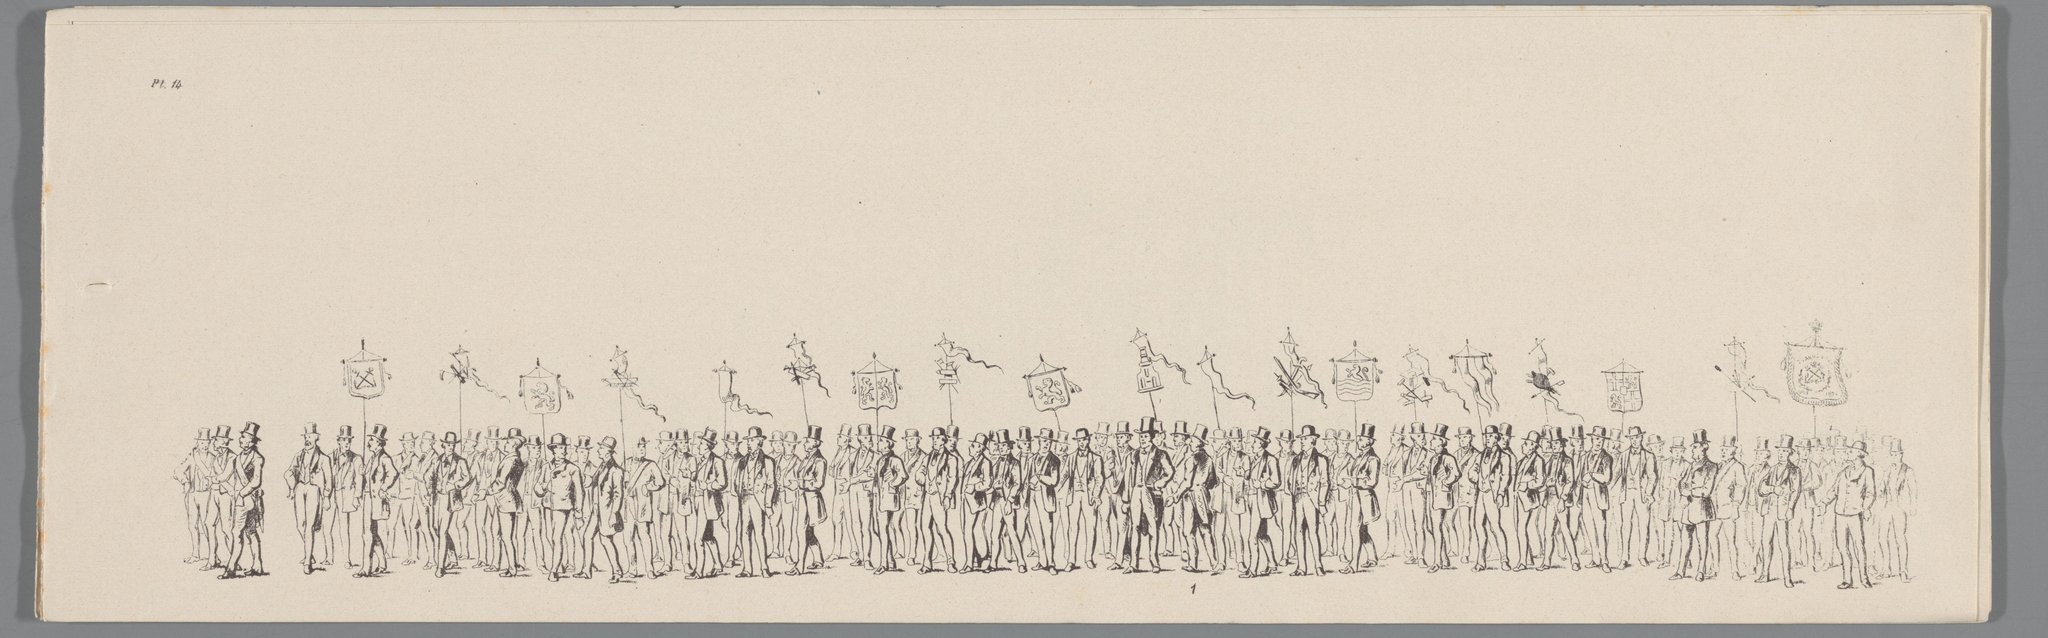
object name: print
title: Historische en Allegorische Optocht te Amsterdam. 12 mei 1874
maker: Anonymous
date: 1874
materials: paper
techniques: lithograph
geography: amsterdam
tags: brussels, willem iii (koning der nederlanden), public festivities at other royal events, not meant or mentioned above (+ parade, pageant, cavalcade ~ festive activities), amsterdam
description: Plaat nr. 14 met het deel van de optocht met de werklieden aan 's Rijks Marinewerf. Onderdeel van een serie van 24 platen van de gekostumeerde historische en allegorische optocht gehouden te Amsterdam op 12 mei 1874, als onderdeel van de feestelijkheden tijdens de viering van het 25-jarige regeringsjubileum van koning Willem III.